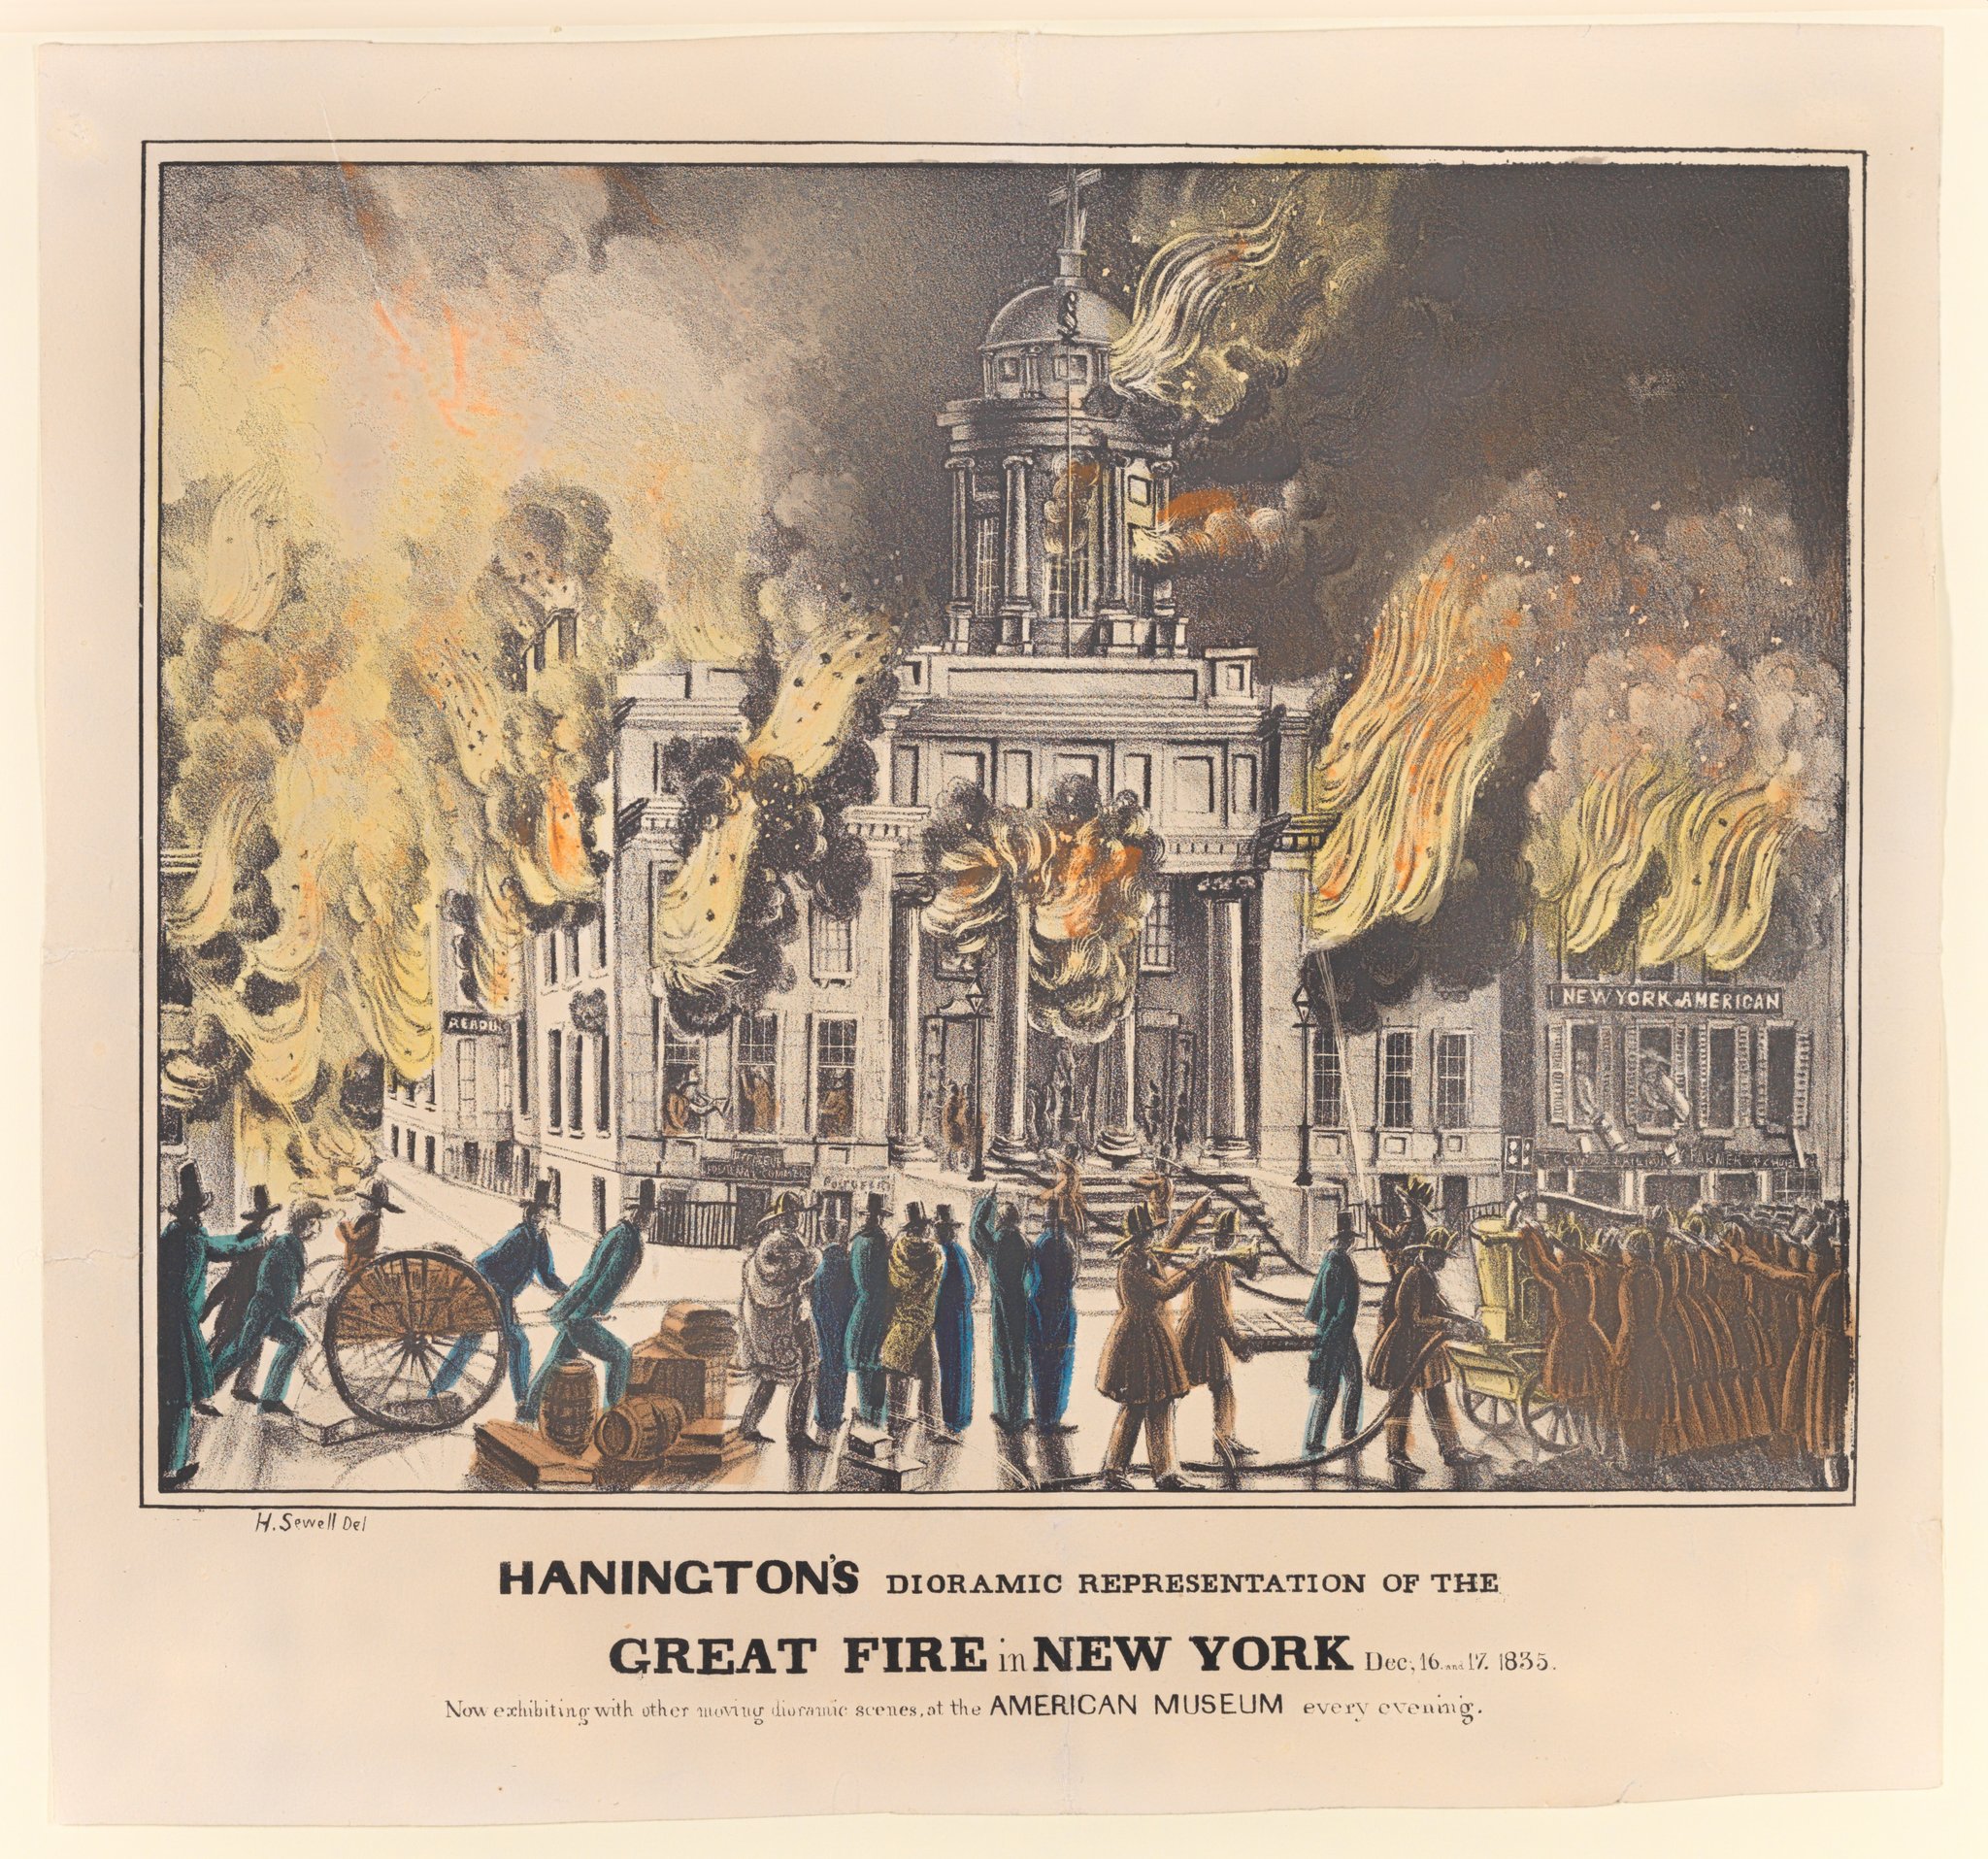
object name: print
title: Hanington's Dioramic Representation of the Great Fire in New York, Dec. 16 and 17, 1835. Now Exhibiting with Other Moving Dioramic Scenes, at the American Museum Every Evening...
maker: h. sewell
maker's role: artist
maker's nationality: american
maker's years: 1836-1837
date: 1836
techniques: hand coloring, lithograph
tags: cities,fire,firefighters,new york city